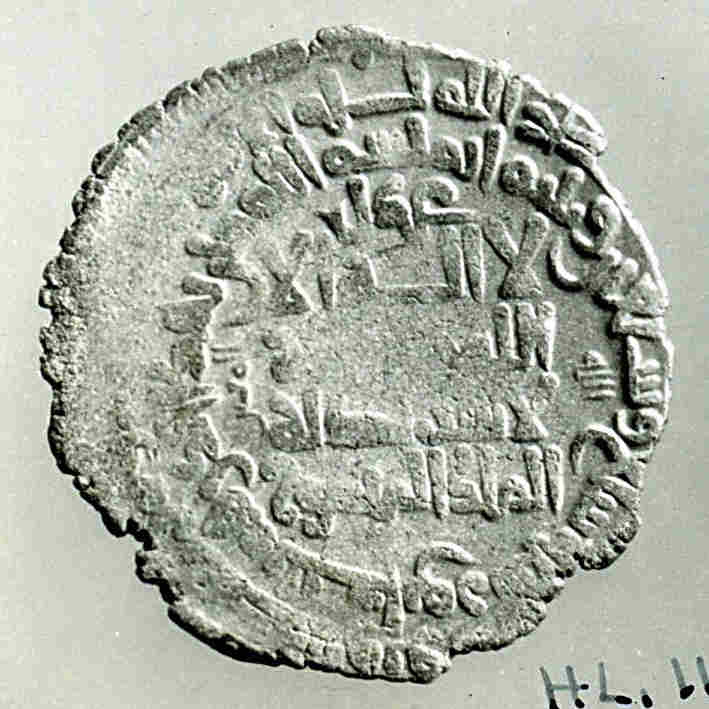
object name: coin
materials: silver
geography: iran